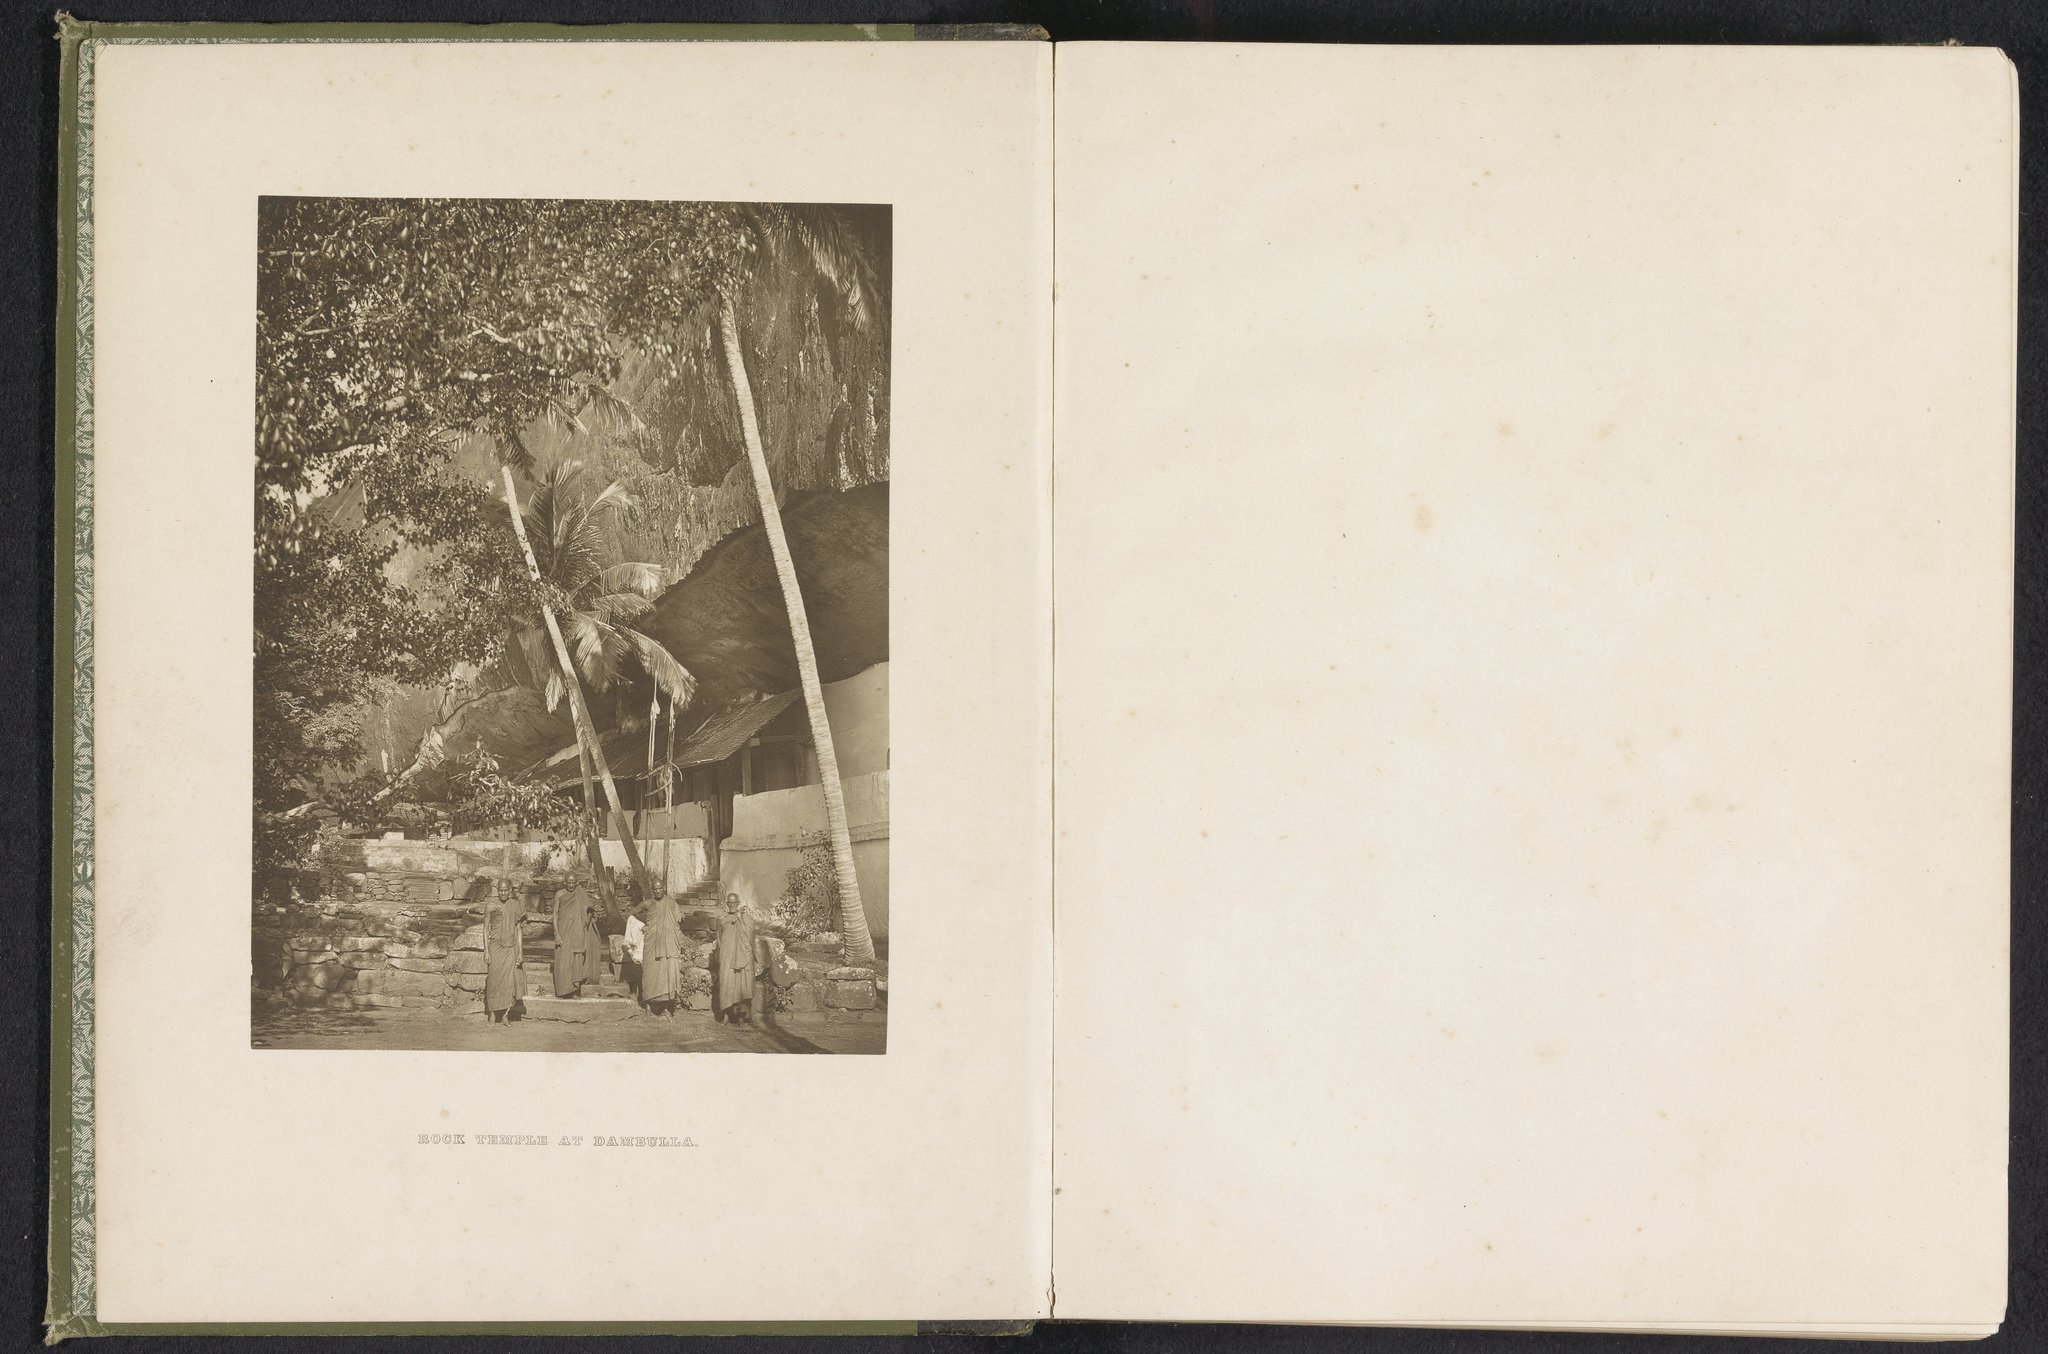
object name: photomechanical print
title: Exterior of the Dambulla Cave Temple, Sri Lanka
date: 1896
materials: paper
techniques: woodburygravure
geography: dambulla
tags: temple, shrine ~ hinduism, buddhism, jainism, temple servants ~ hinduism, buddhism, jainism, rock-formations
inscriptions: title: ‘ROCK TEMPLE AT DAMBULLA.’